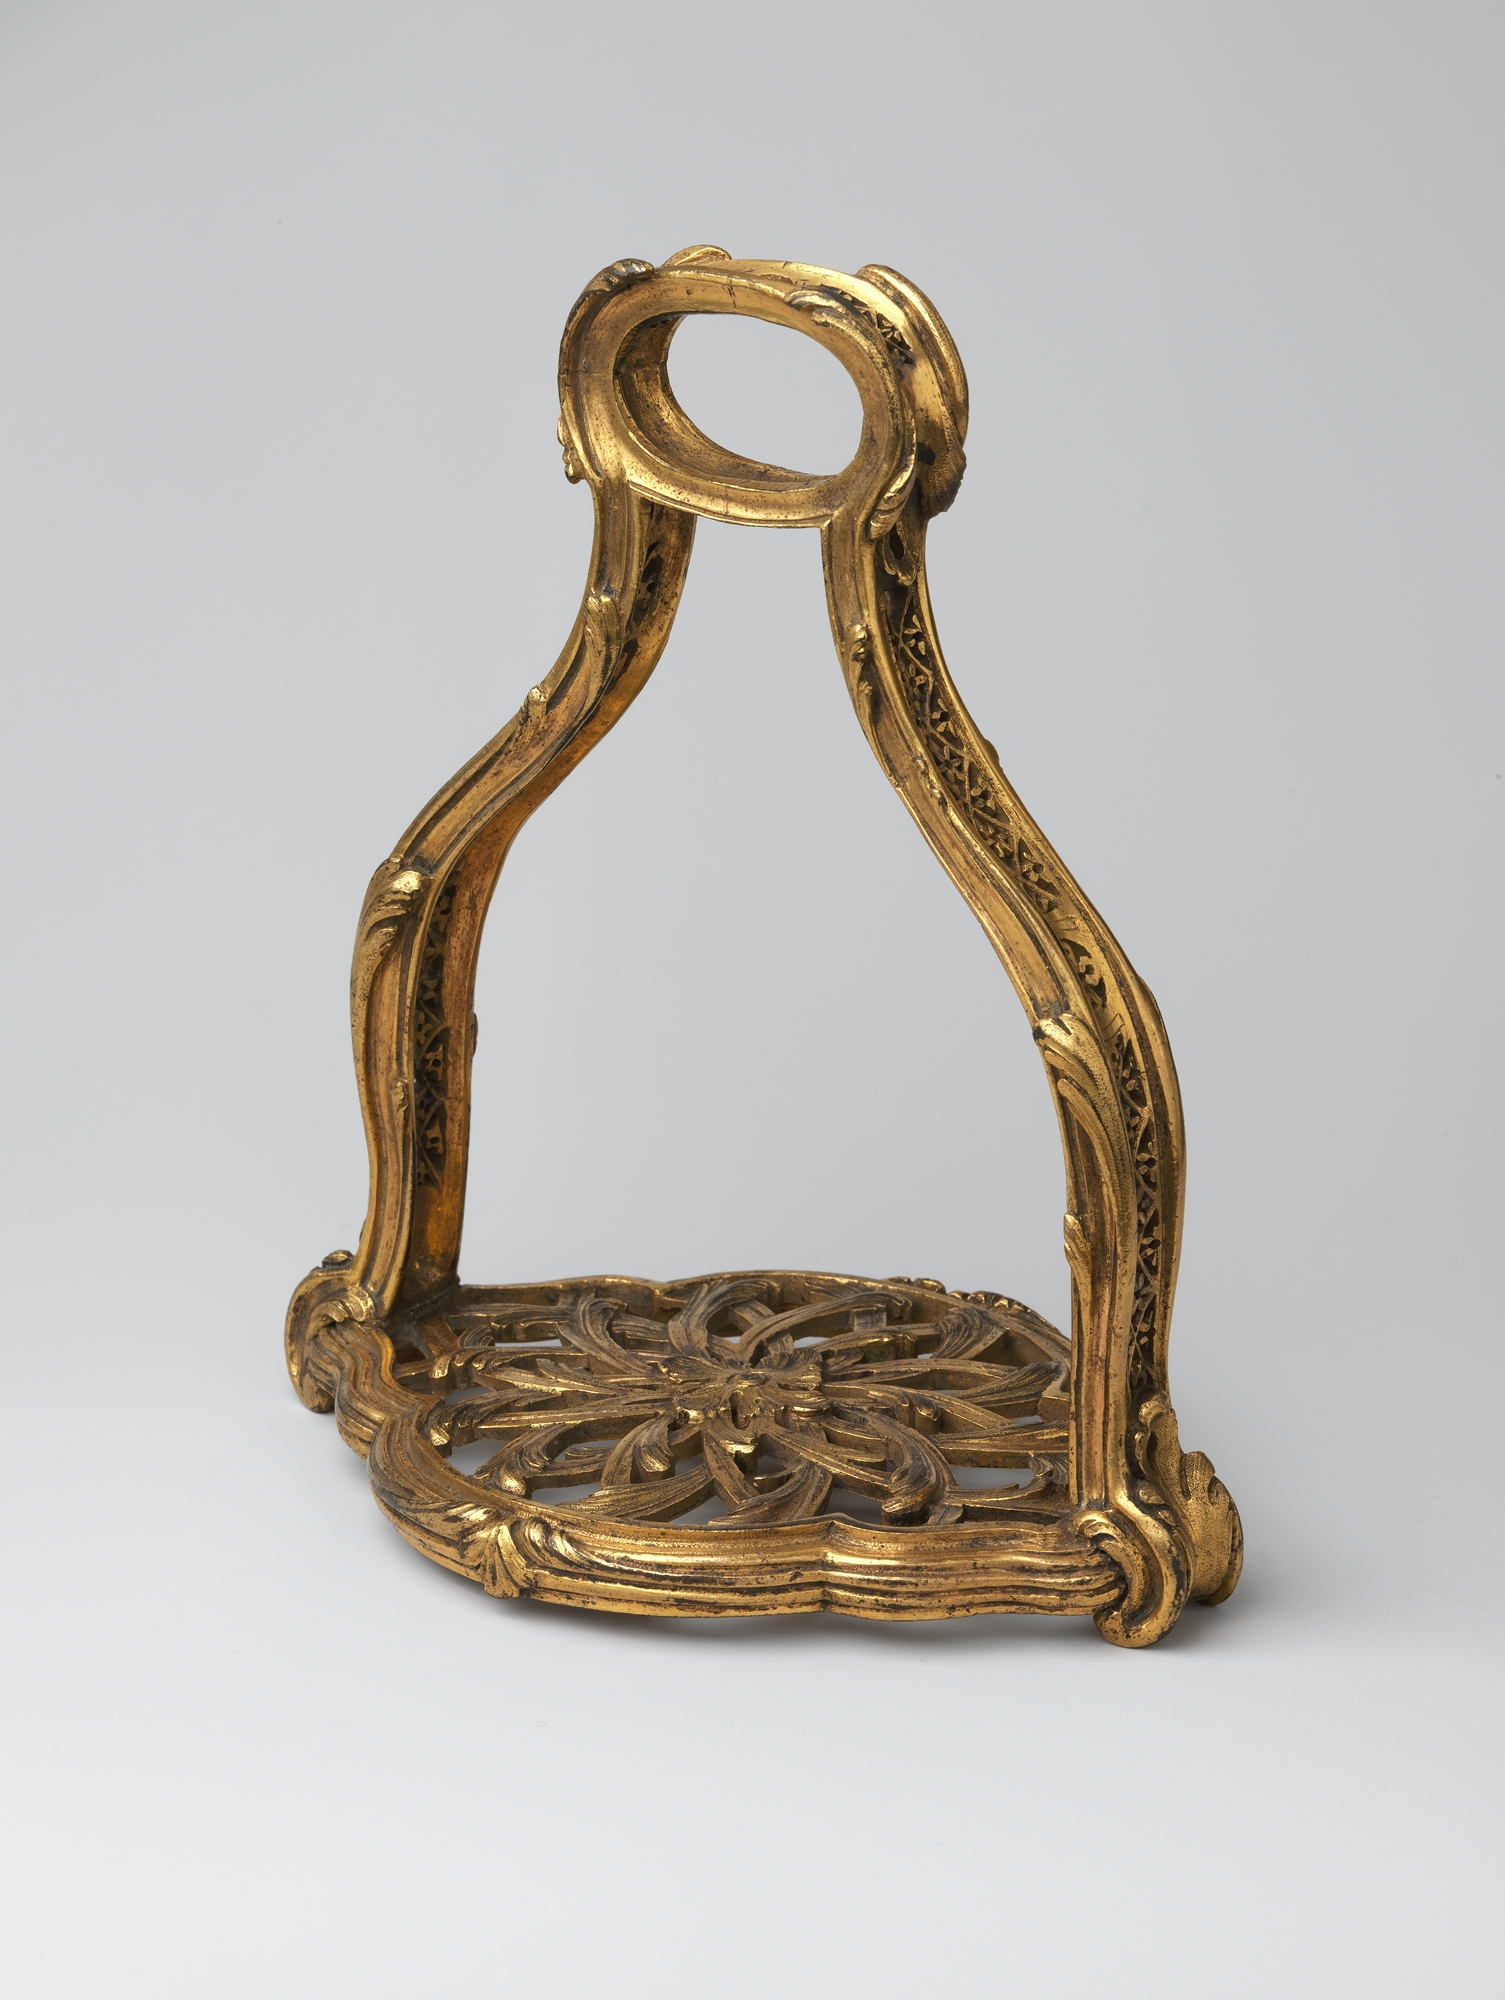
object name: stirrup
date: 1701-1800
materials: gilt bronze